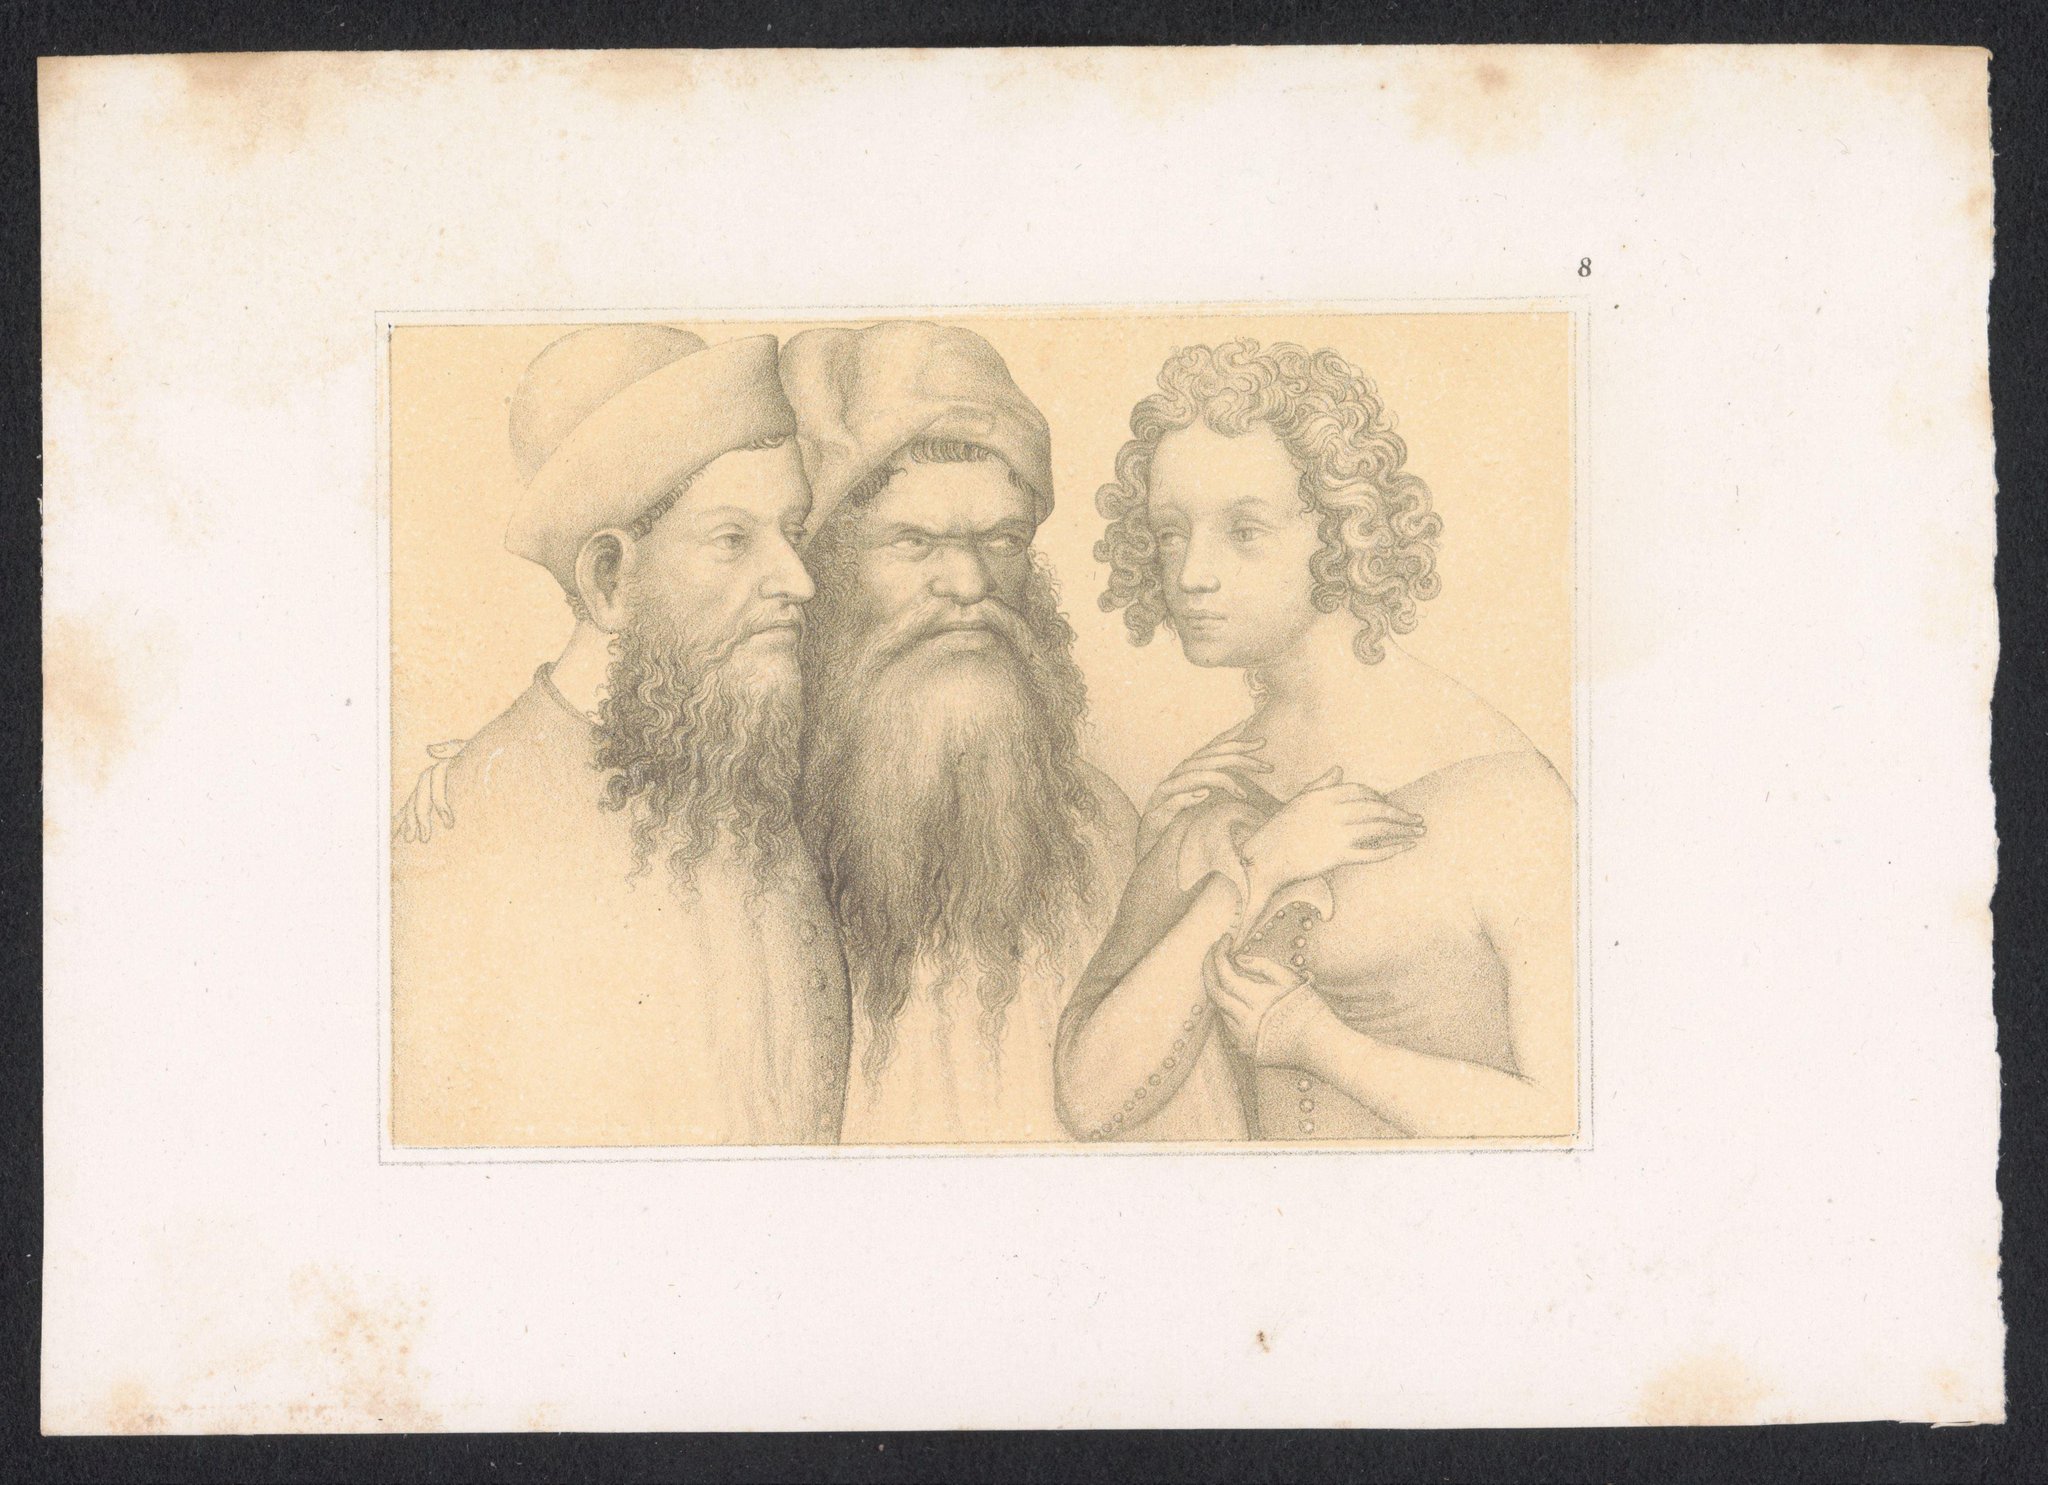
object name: print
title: Entwürfe und Studien eines niederländischen Meisters aus dem XV. Jahrhundert. Nach den in der Königlichen Bibliothek zu Berlin aufbewahrten Originalen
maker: karl palzow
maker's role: print maker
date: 1830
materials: paper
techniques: tone lithography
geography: berlin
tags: the story of susanna and the elders (in which the youth daniel intervenes on behalf of susanna) (daniel 13)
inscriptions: collector's mark: Lugt 2228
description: Een jonge vrouw staat tegenover twee oude mannen. Vermoedelijk Susanna en de ouderen. Prent is onderdeel van een omslag met tekst en een serie van achttien lithografieën naar schilderijen van Nederlandse meesters.